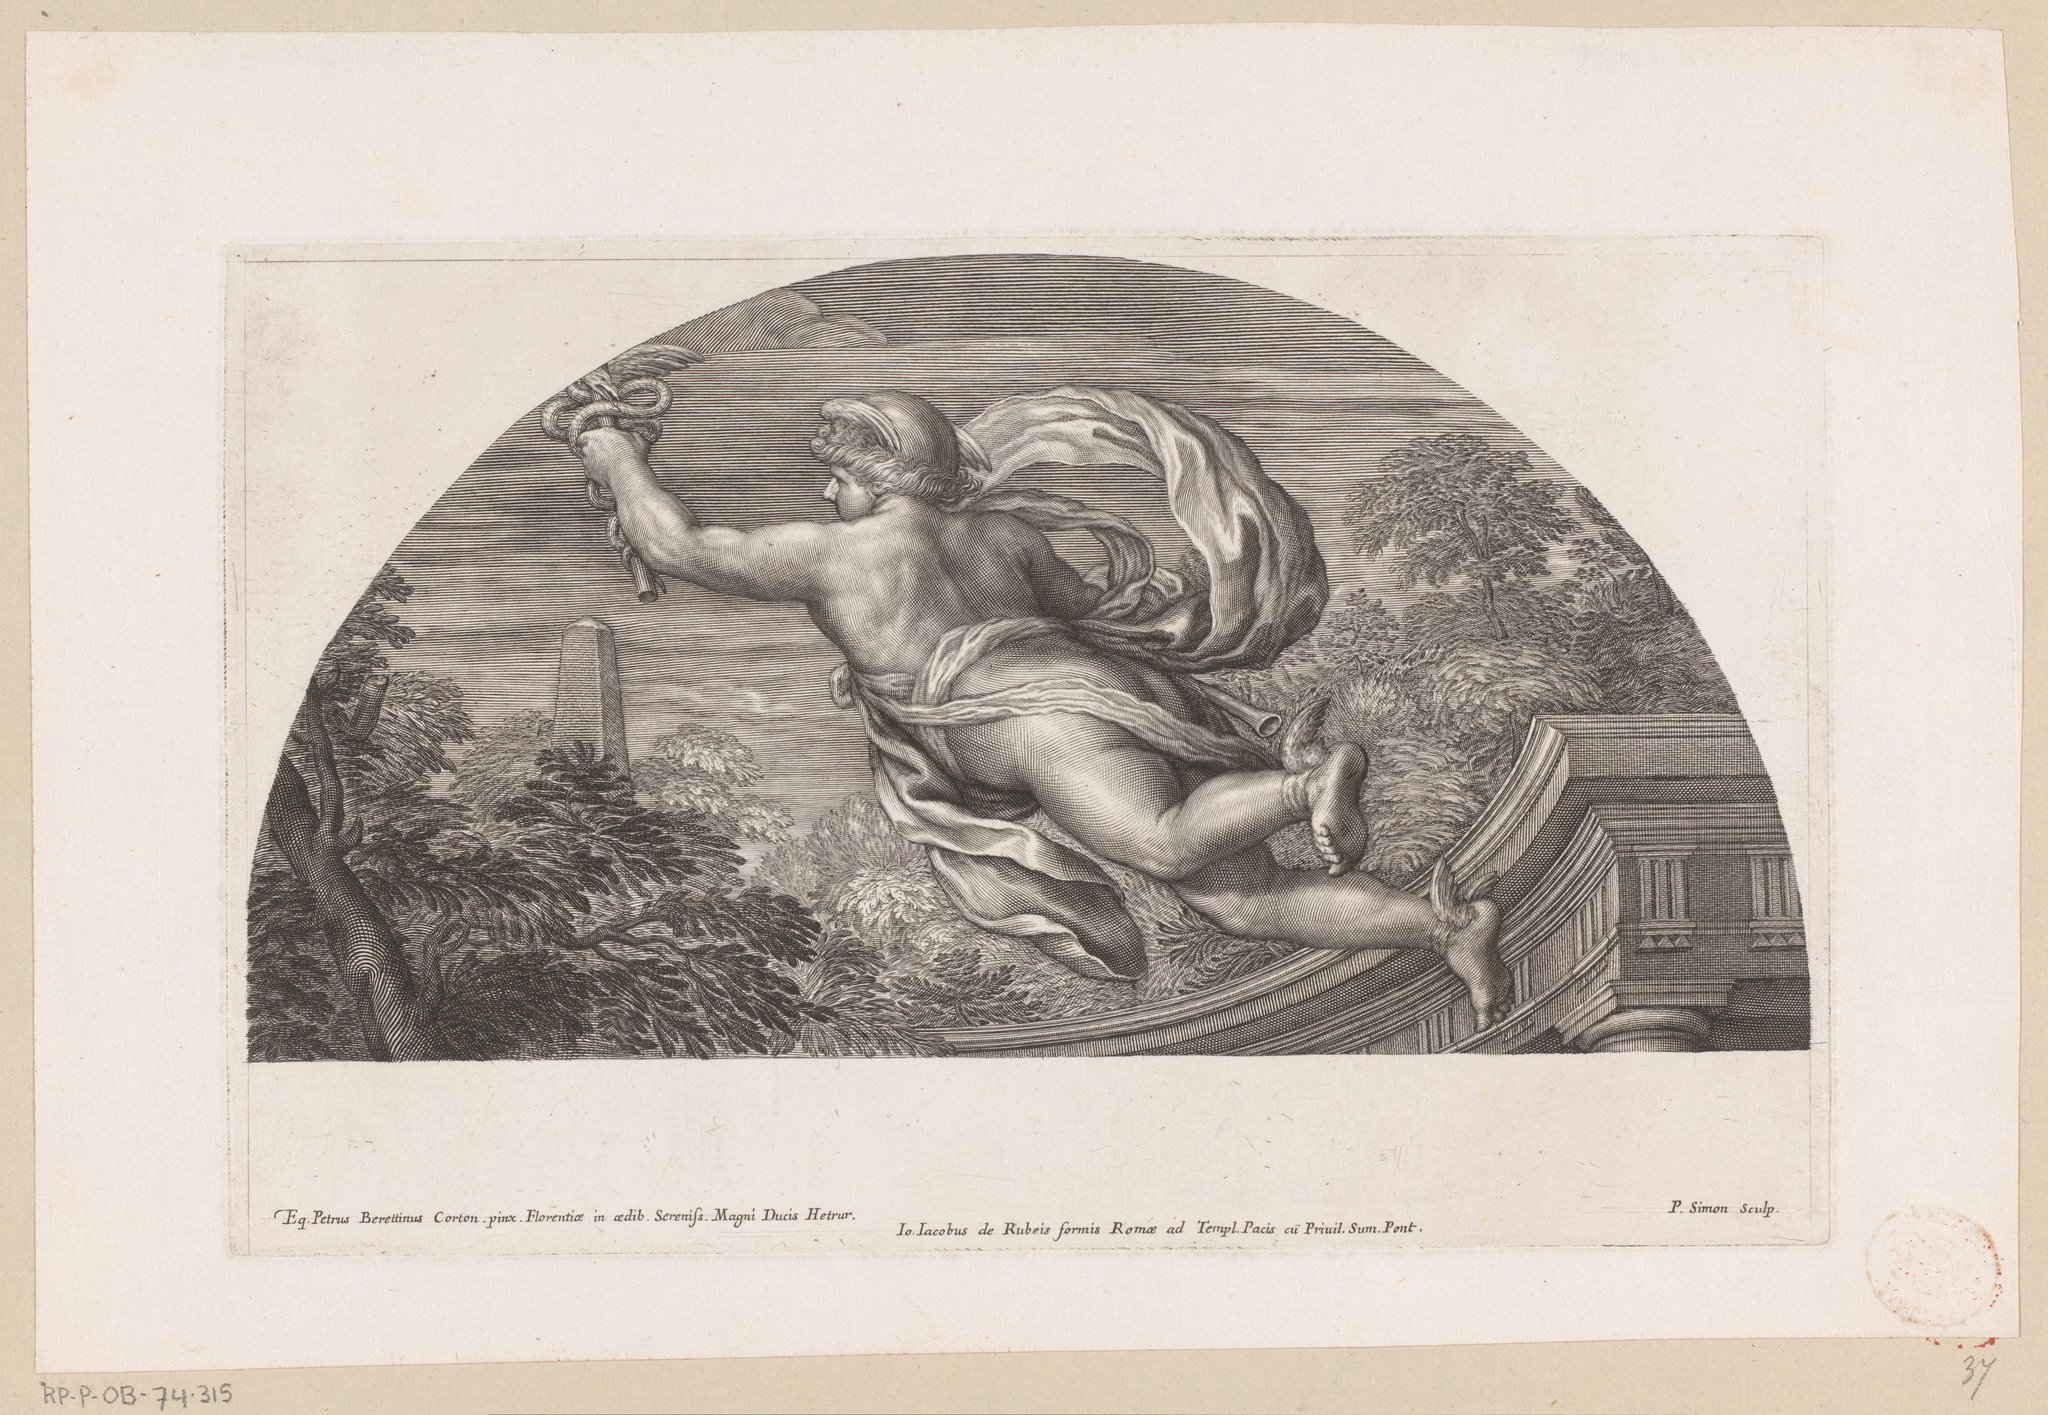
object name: print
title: Voorstellingen van heroïsche daden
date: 1645-1691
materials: paper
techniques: engraving, etching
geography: rome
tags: (story of) mercury (hermes)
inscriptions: collector's mark: Lugt 240